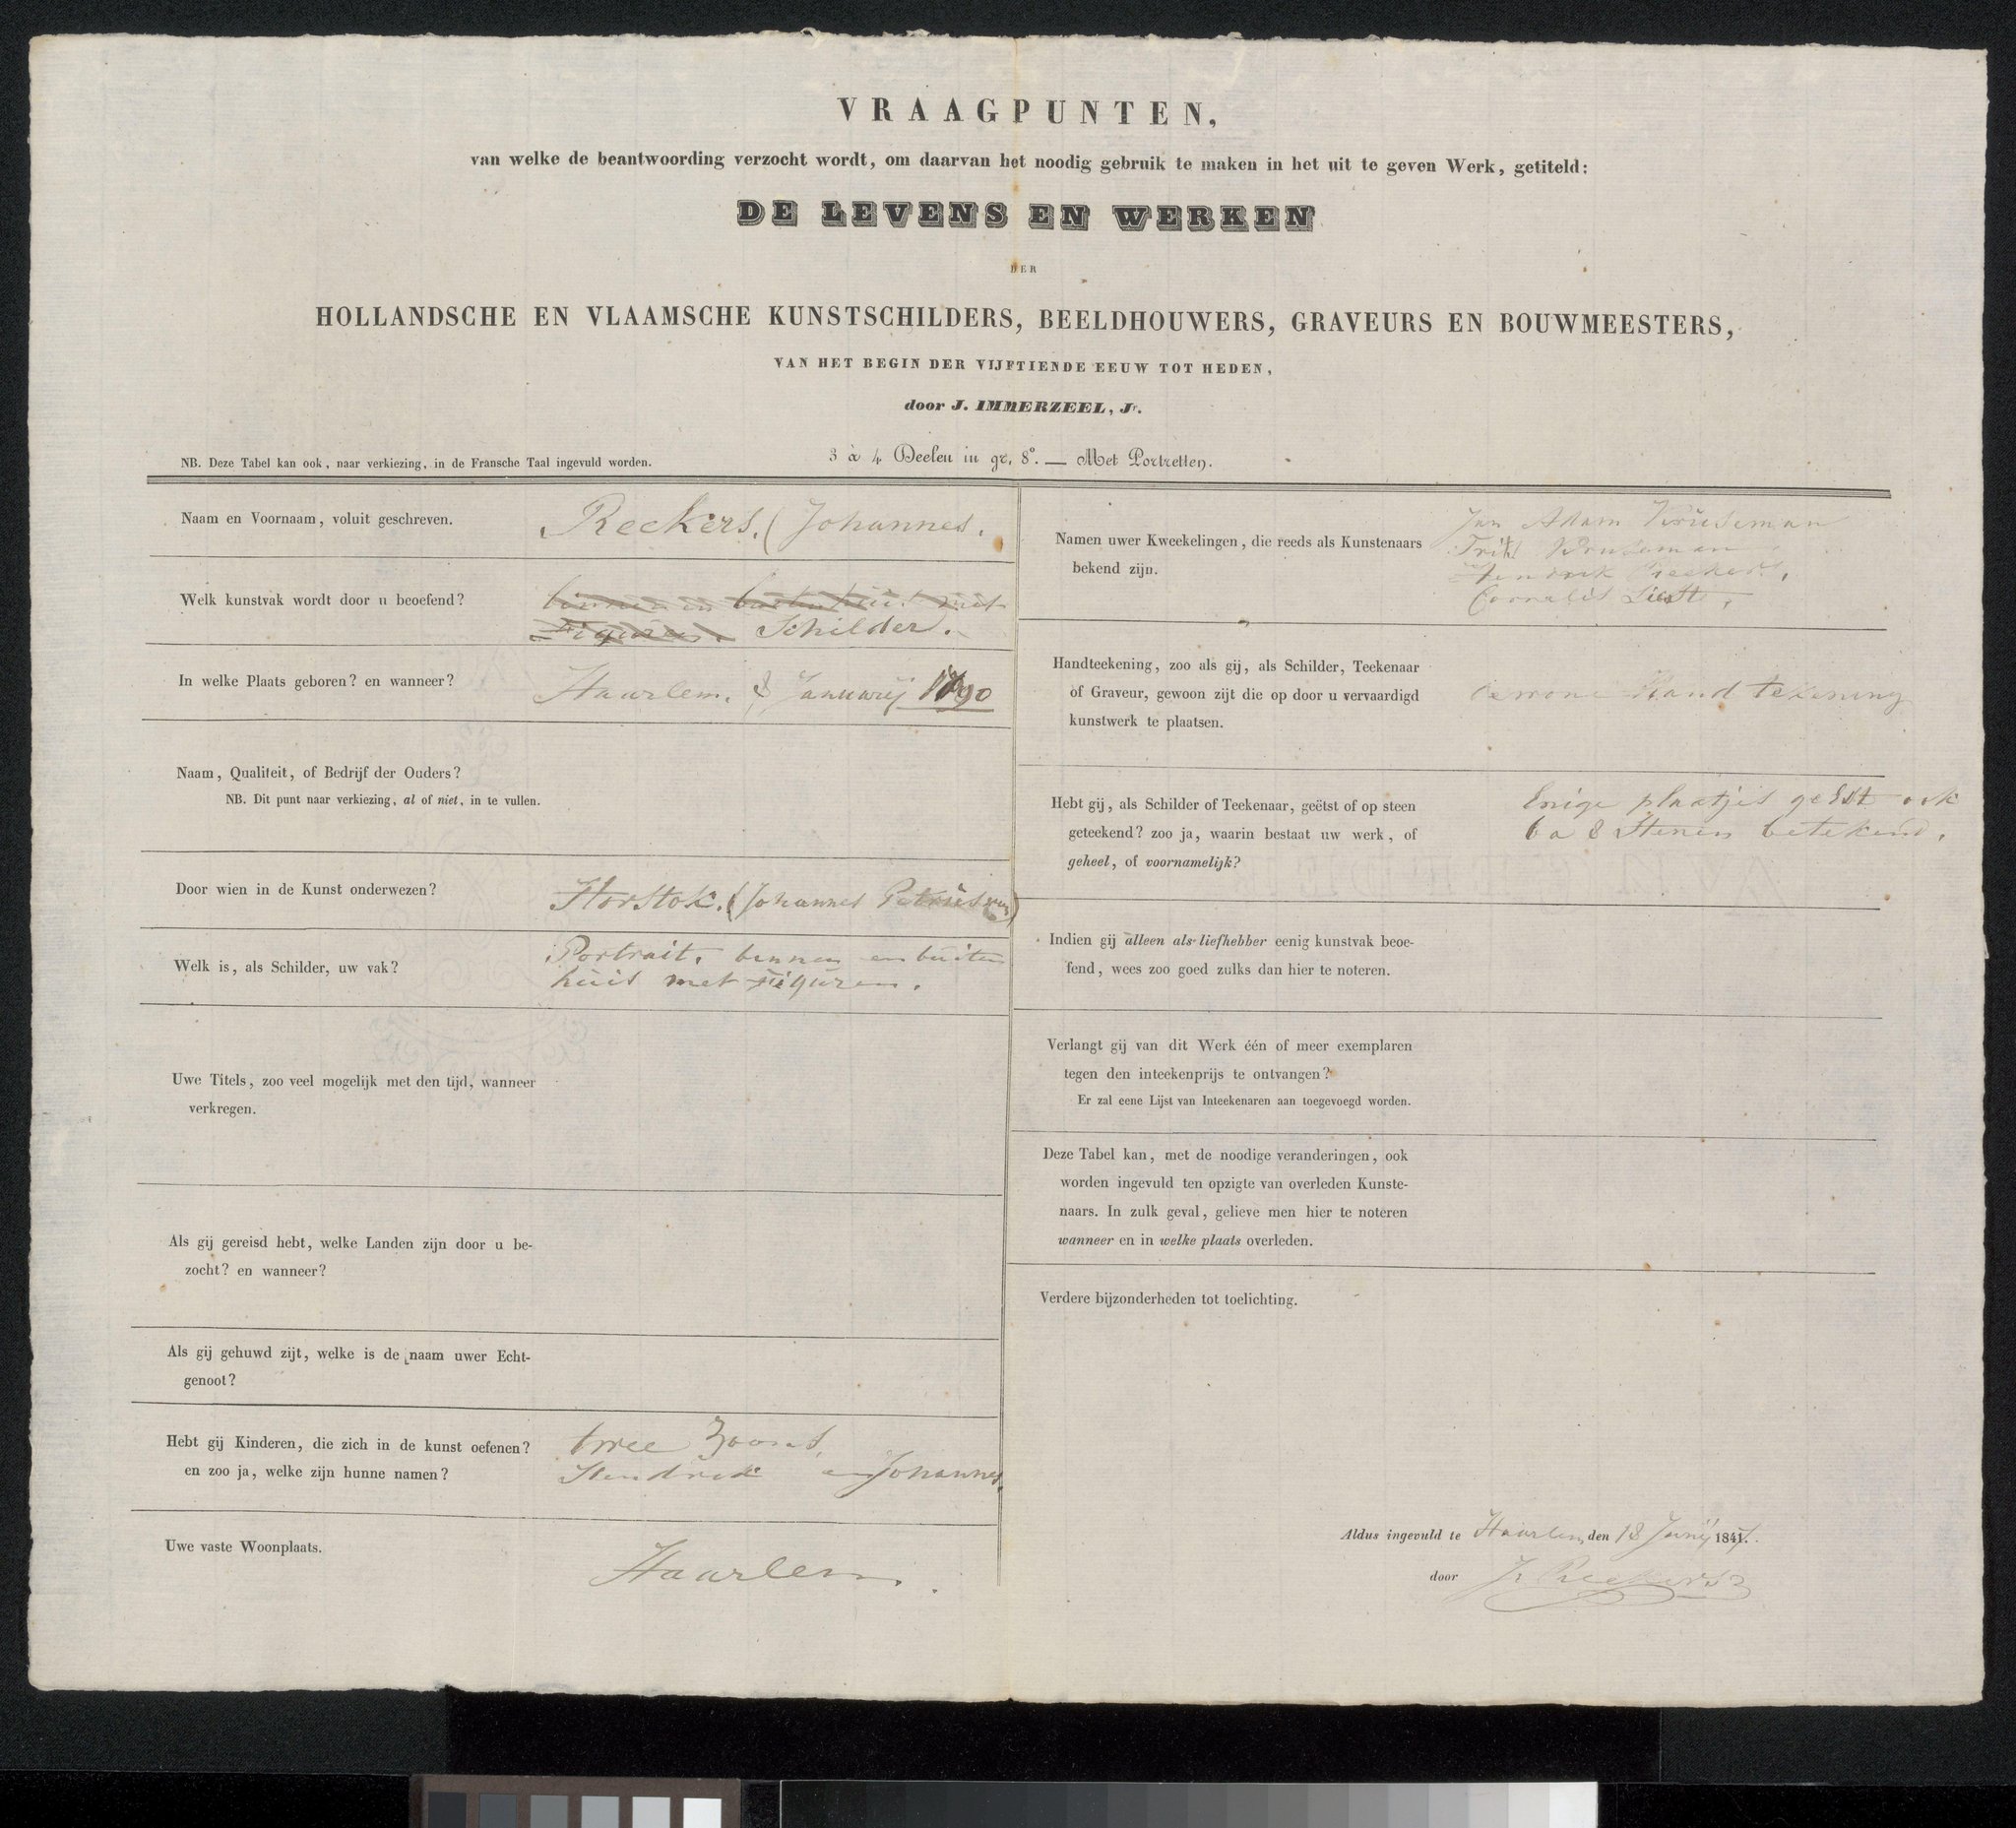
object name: manuscript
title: Enquêteformulier ingevuld door Johannes Reekers (I)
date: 1847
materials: ink, paper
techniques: pen, printing, writing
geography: haarlem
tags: haarlem, johannes reekers (i)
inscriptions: inscription: ‘Vraagpunten,/ van welke de beantwoording verzocht wordt, om daarvan het noodig gebruik te maken in het uit te geven Werk, getiteld: De levens en werken/ der Hollandsche en Vlaamsche kunstschilders, beeldhouwers,/ graveurs en bouwmeesters, van het begin der vijftiende eeuw tot heden/ door J. Immerzeel, Jr.’, watermark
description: Opgenomen in: Immerzeel, J. Jr., De levens en werken der Hollandsche en Vlaamsche kunstschilders, beeldhouwers, graveurs en bouwmeesters, van het begin der vijftiende eeuw tot heden, Amsterdam: J.C. van Kesteren, 1842-1843.